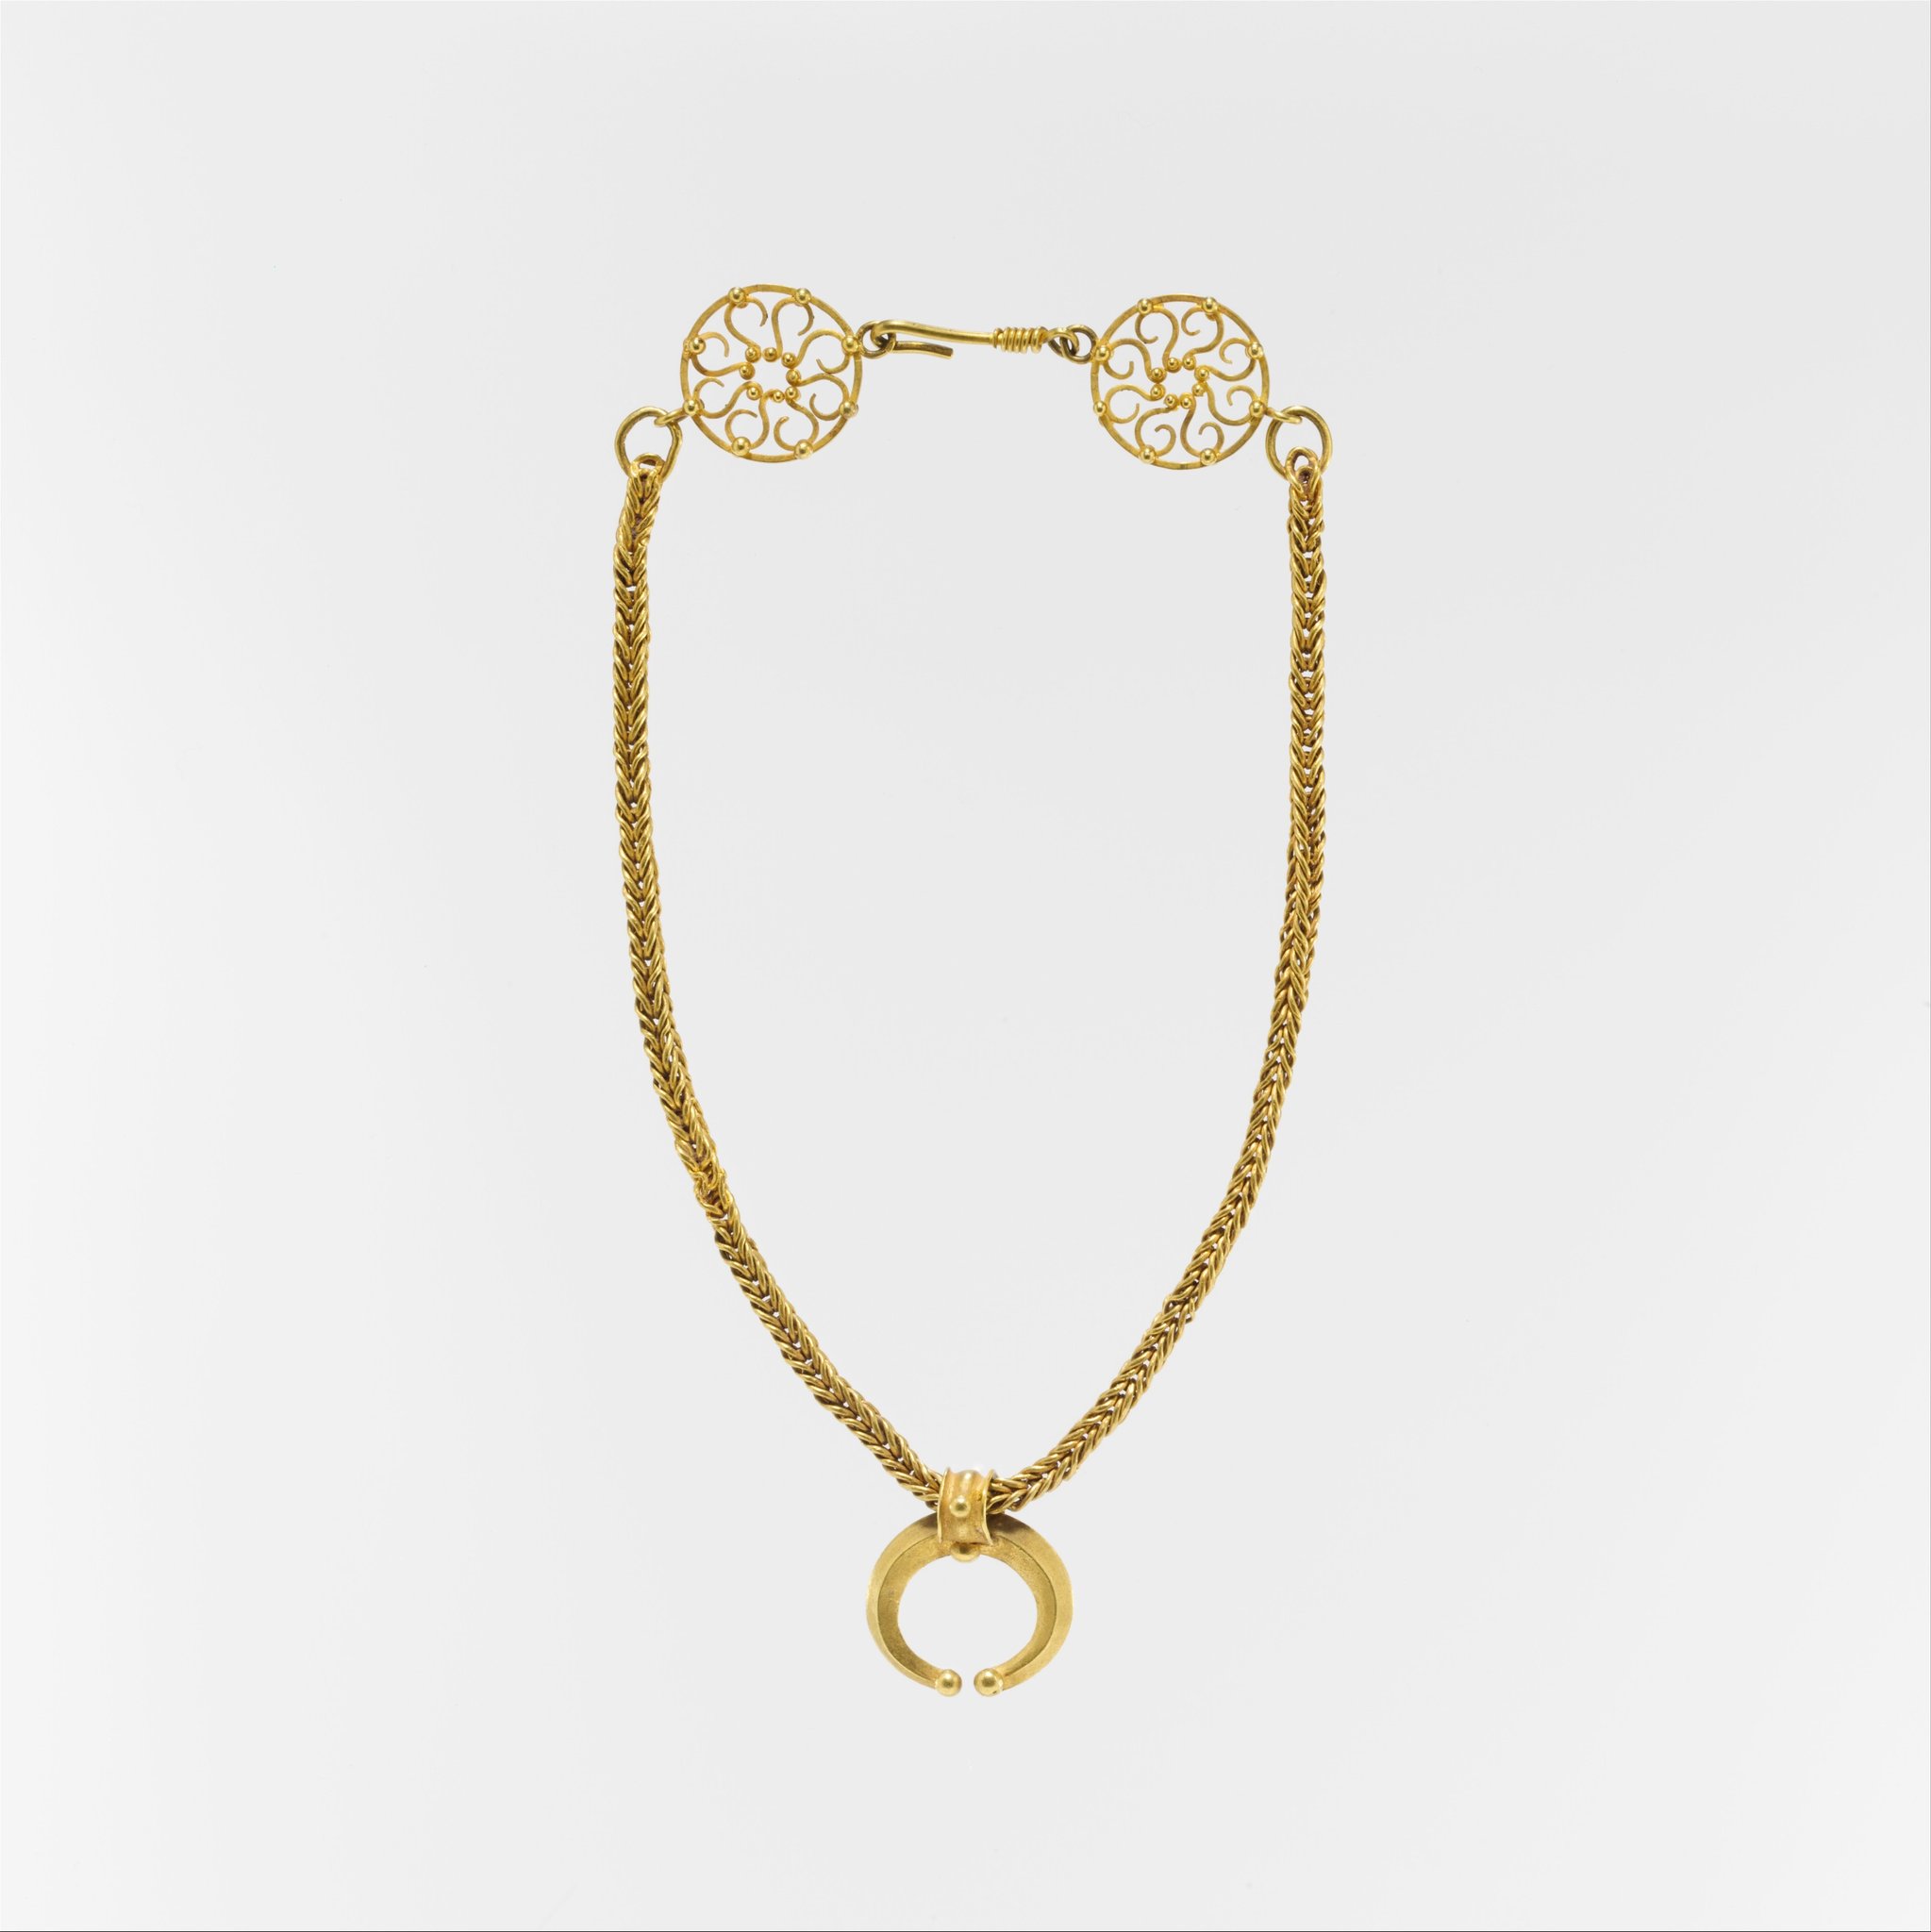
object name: necklace with pendant in the form of a crescent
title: Gold necklace with crescent-shaped pendant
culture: roman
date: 1-300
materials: gold